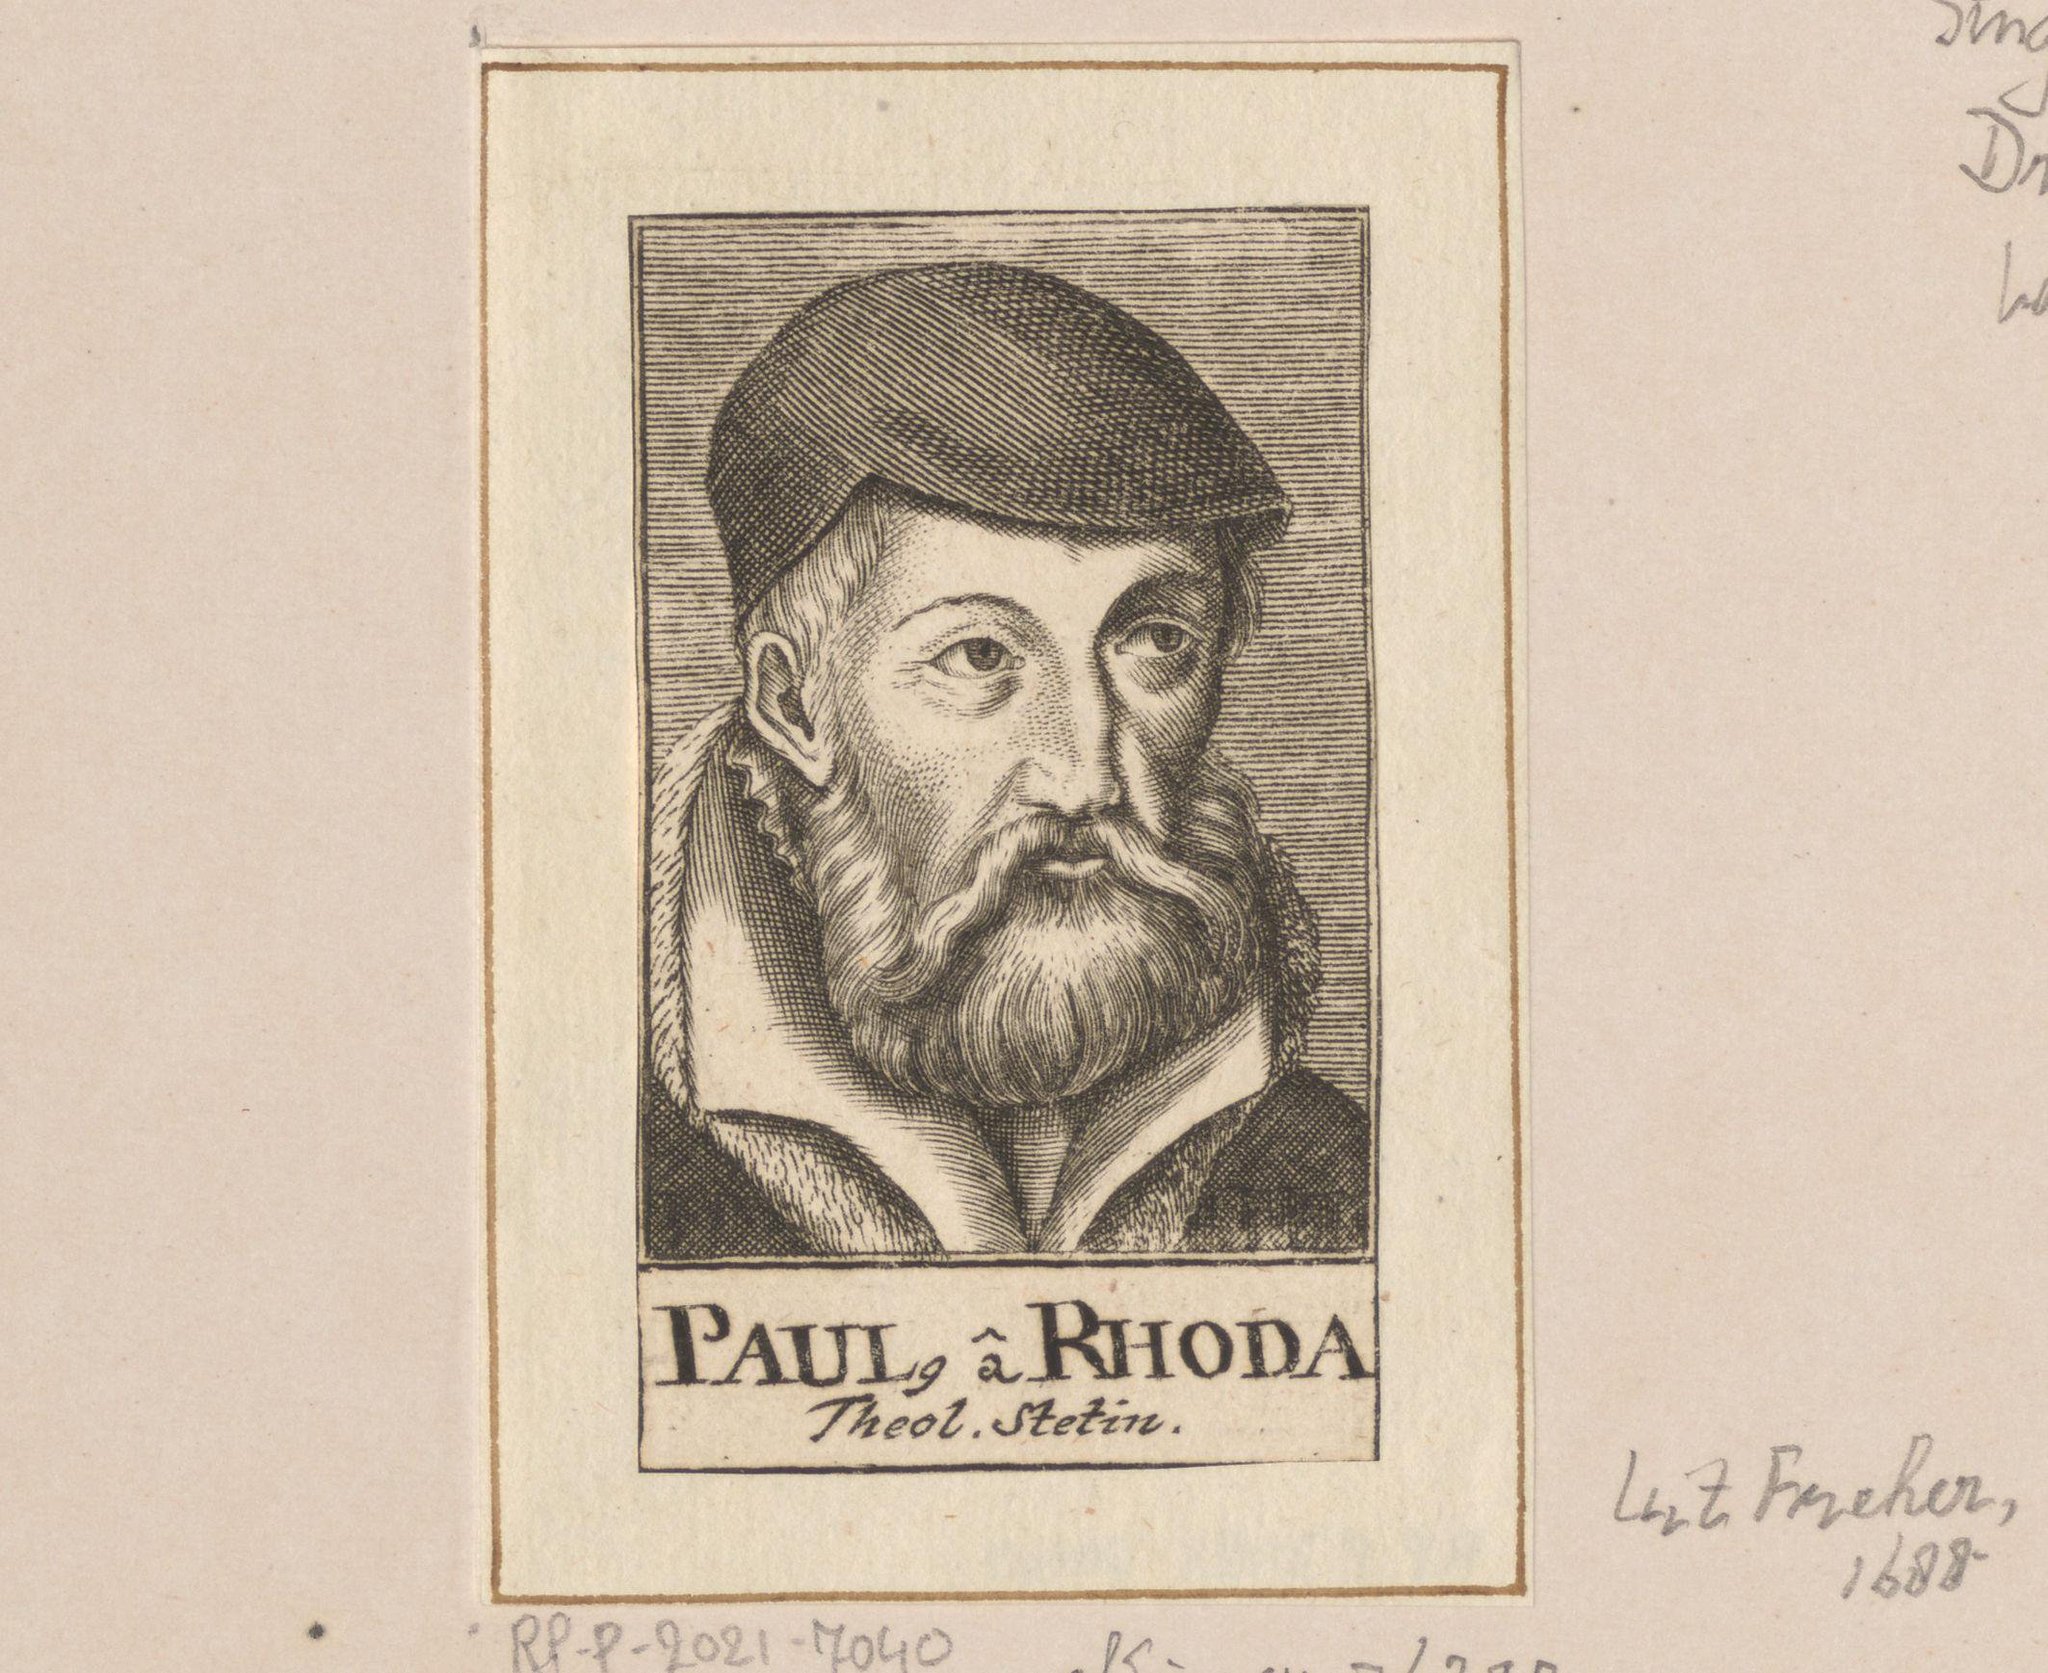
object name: print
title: Portret van Paulus Rode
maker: Anonymous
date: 1688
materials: paper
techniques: engraving, etching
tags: historical persons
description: Prent maakt deel uit van een grotere prent die later is verknipt. Prent waarschijnlijk uit: Freher, Paul. Theatrum virorum eruditione clarorum. Neurenberg: Johann Hoffmann, 1688.